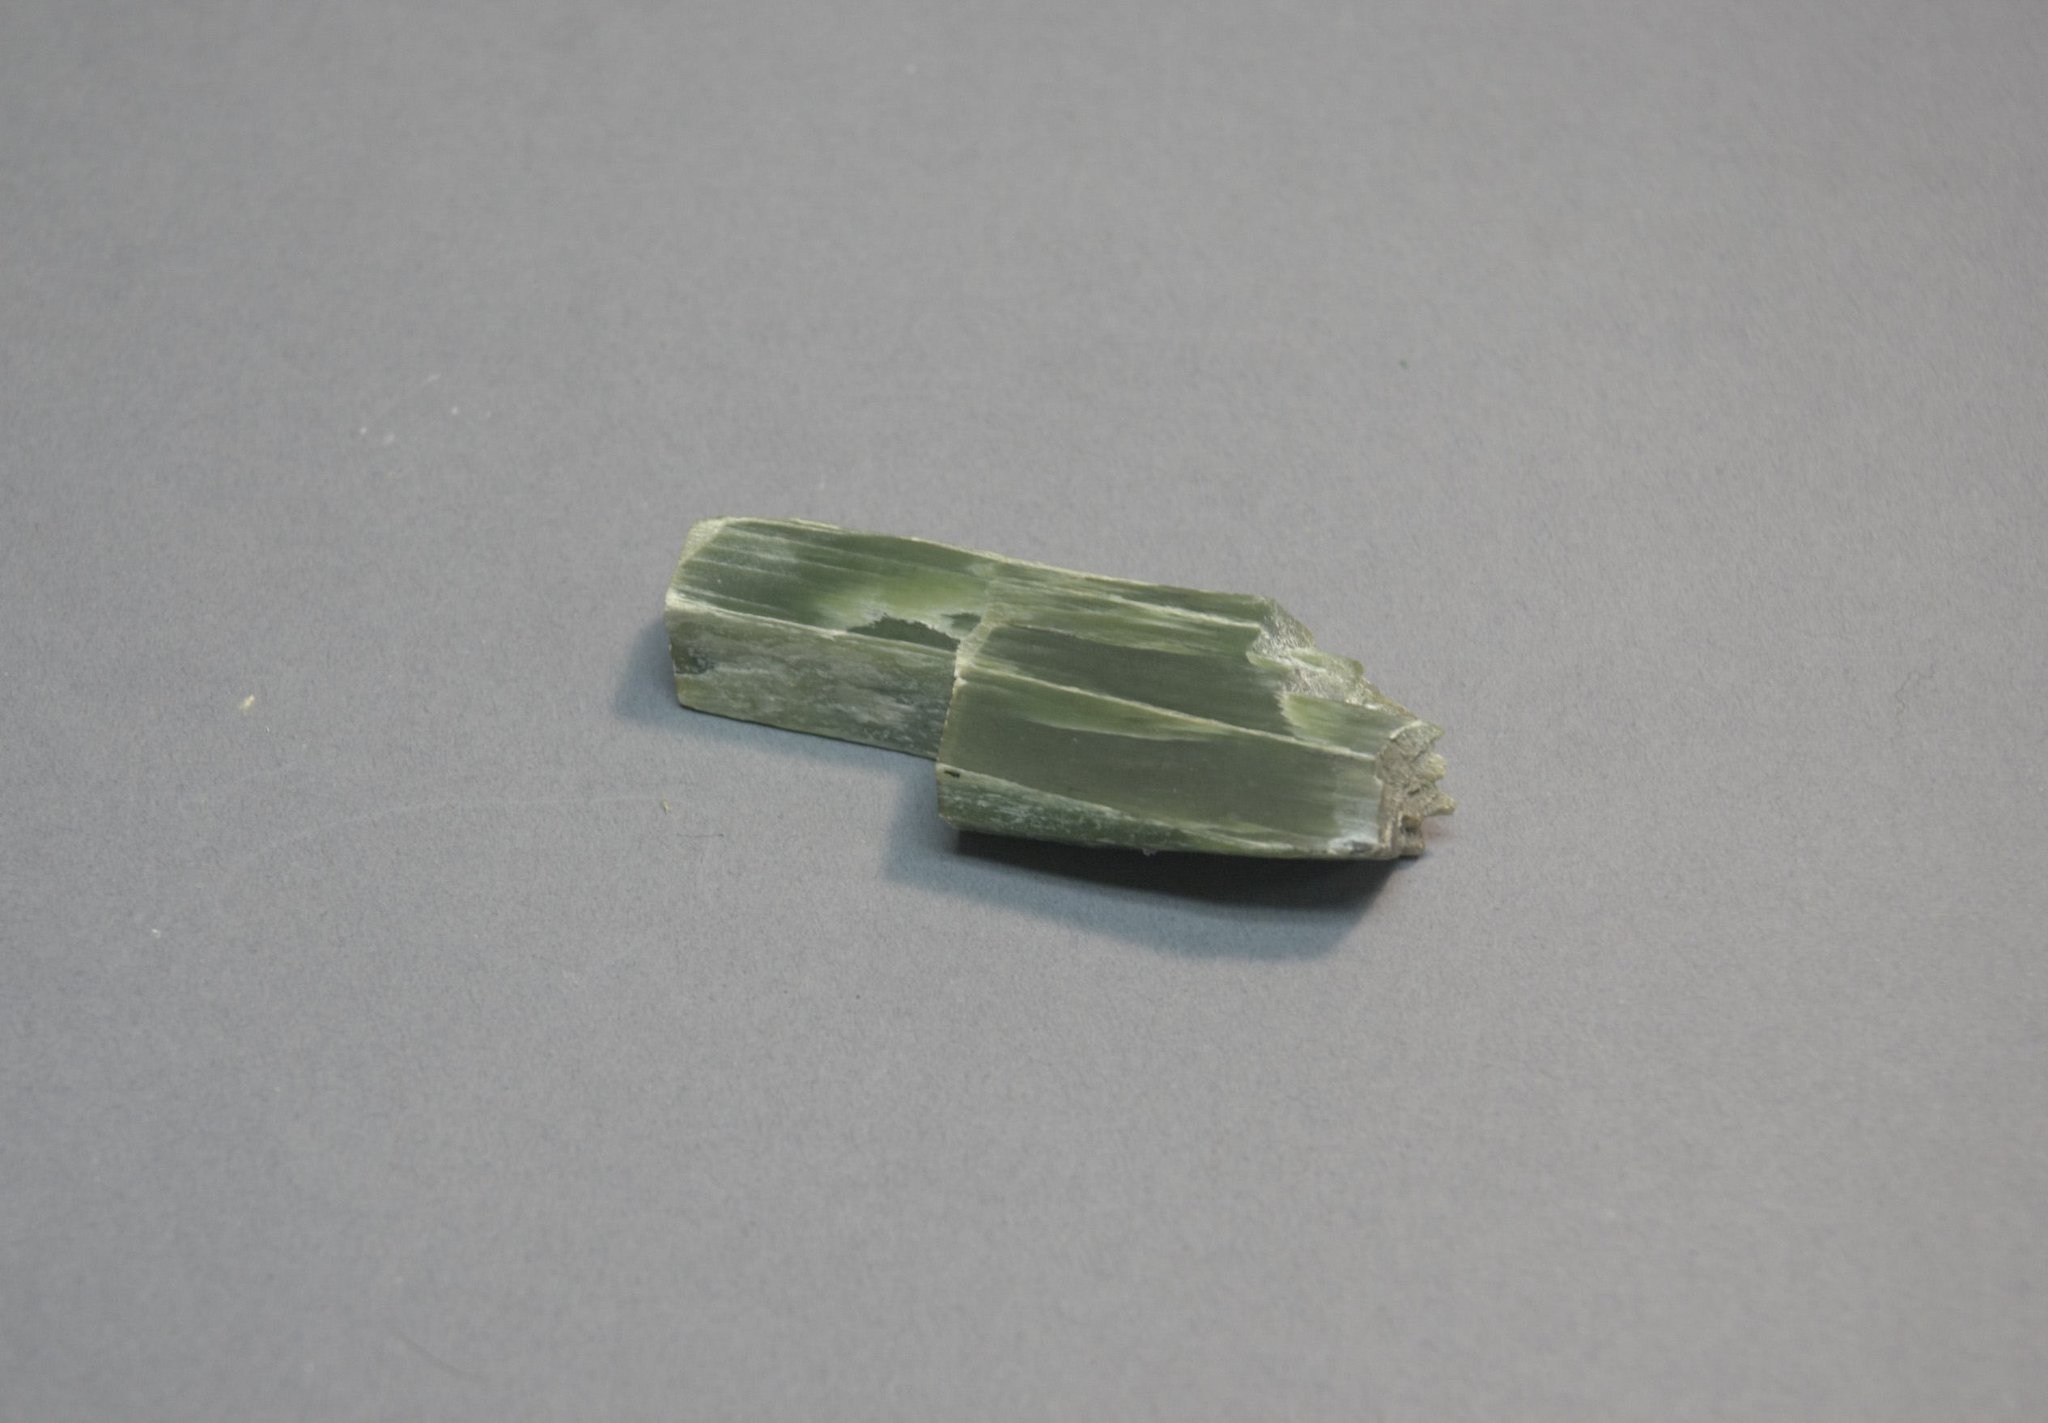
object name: jade carving material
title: Piece of Nephrite from Daiwan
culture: chinese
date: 1901-2000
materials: jade